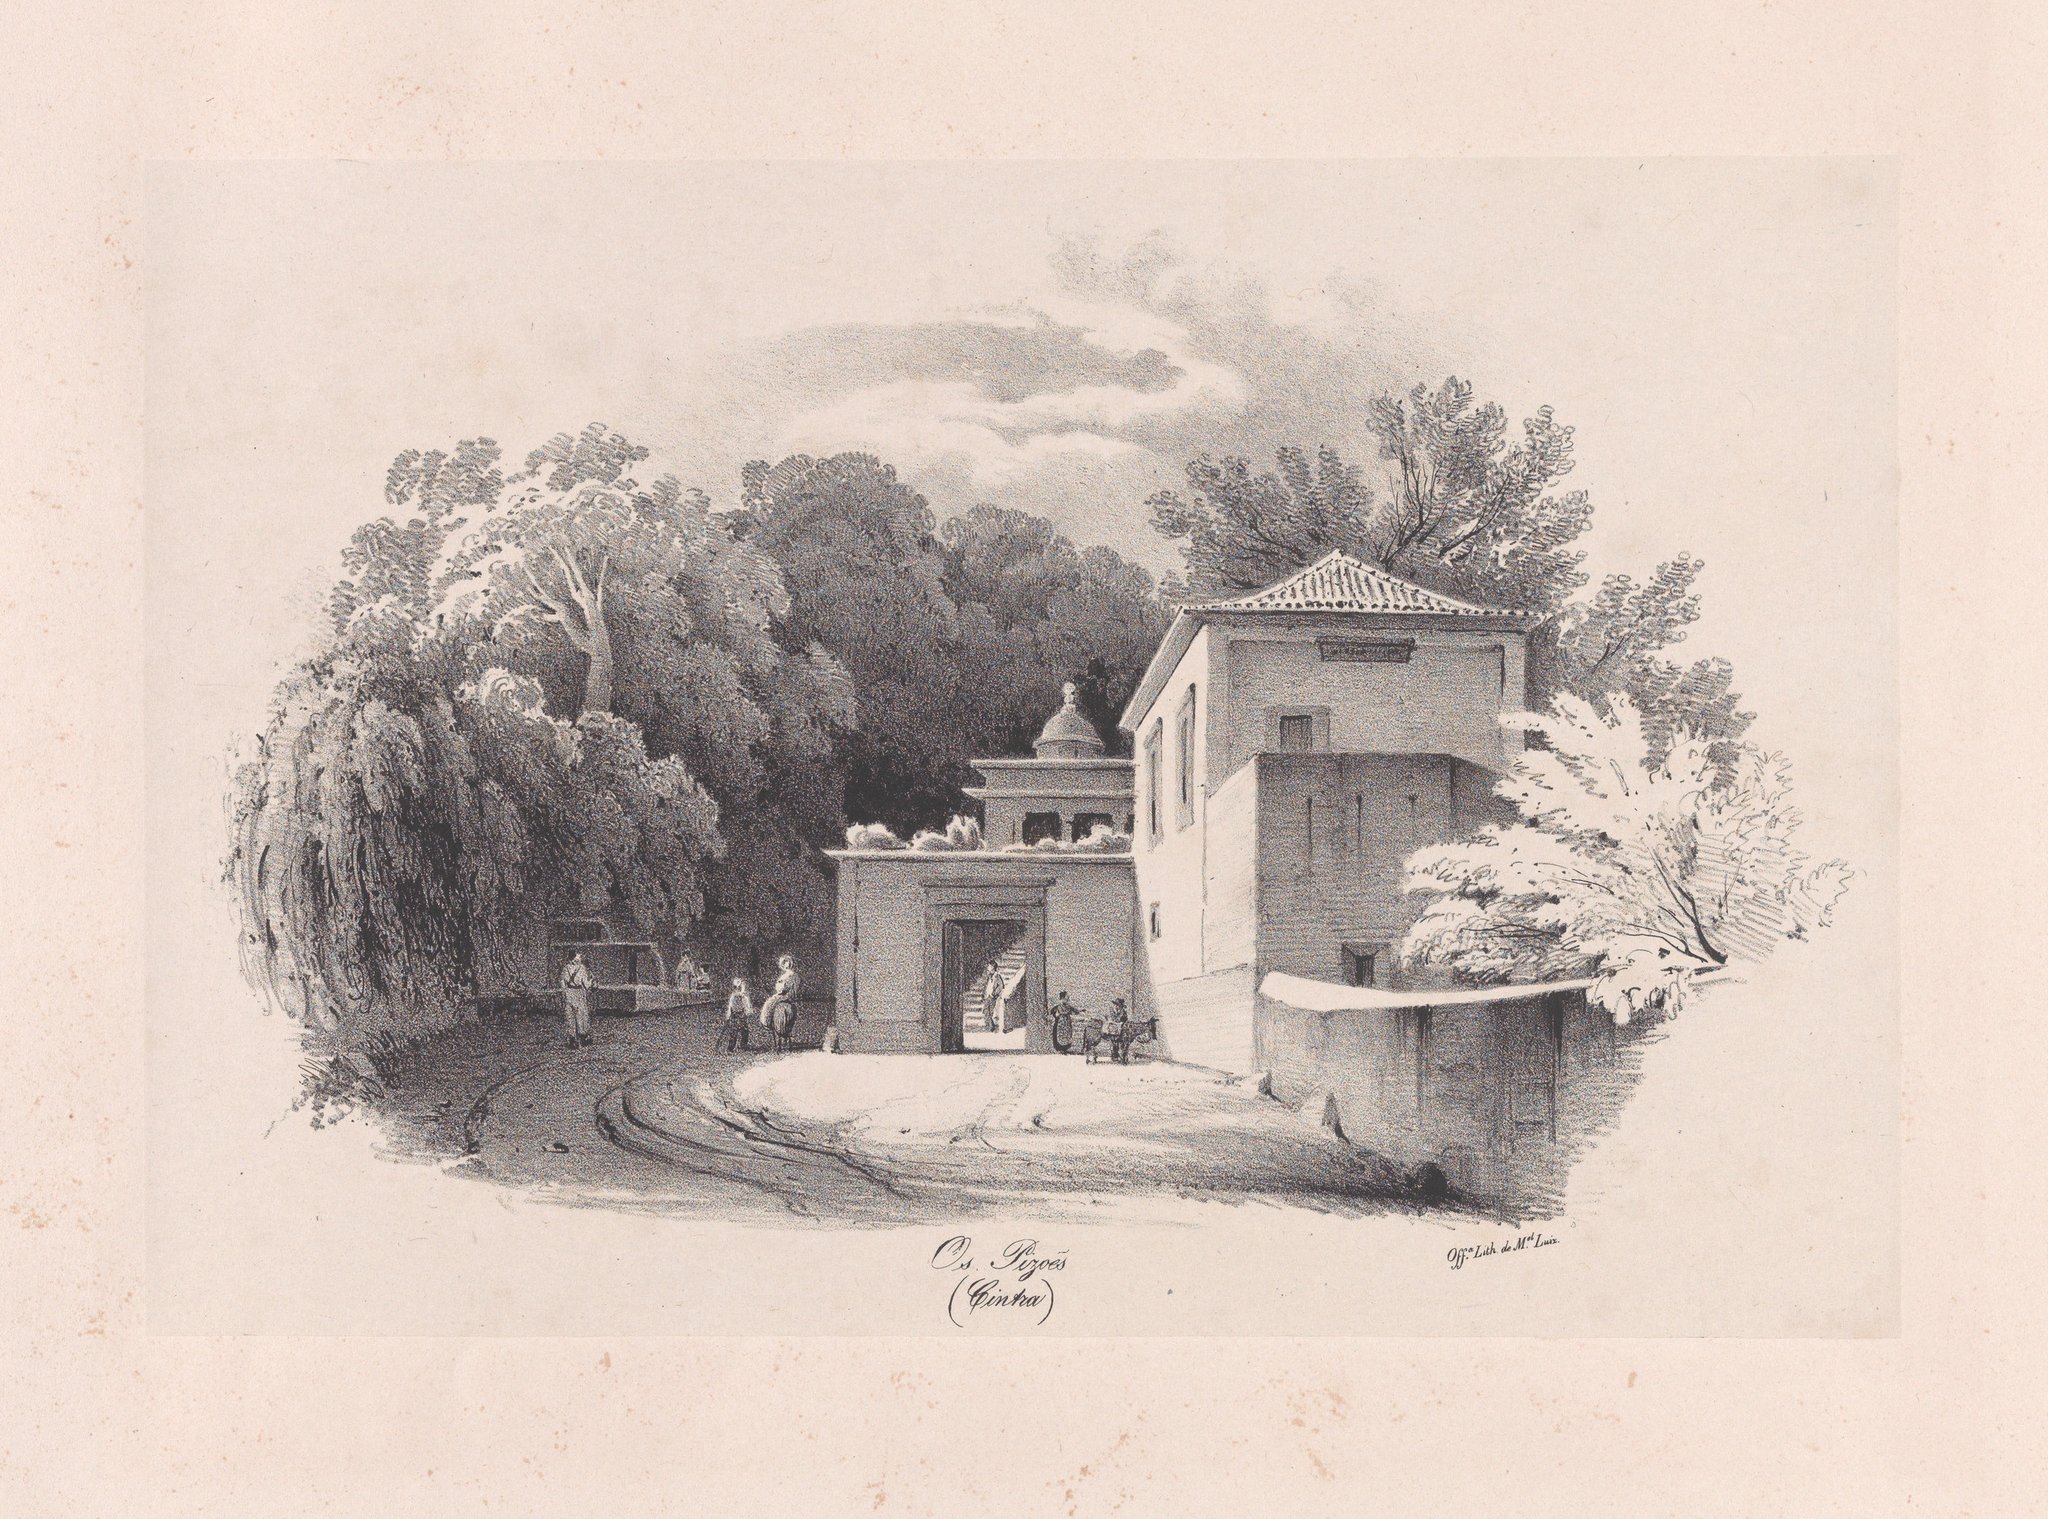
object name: print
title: View of the Quinta dos Pizões, Sintra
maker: clementine de brelaz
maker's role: artist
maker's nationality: portuguese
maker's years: 1811-1892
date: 1840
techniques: printmaking, lithograph